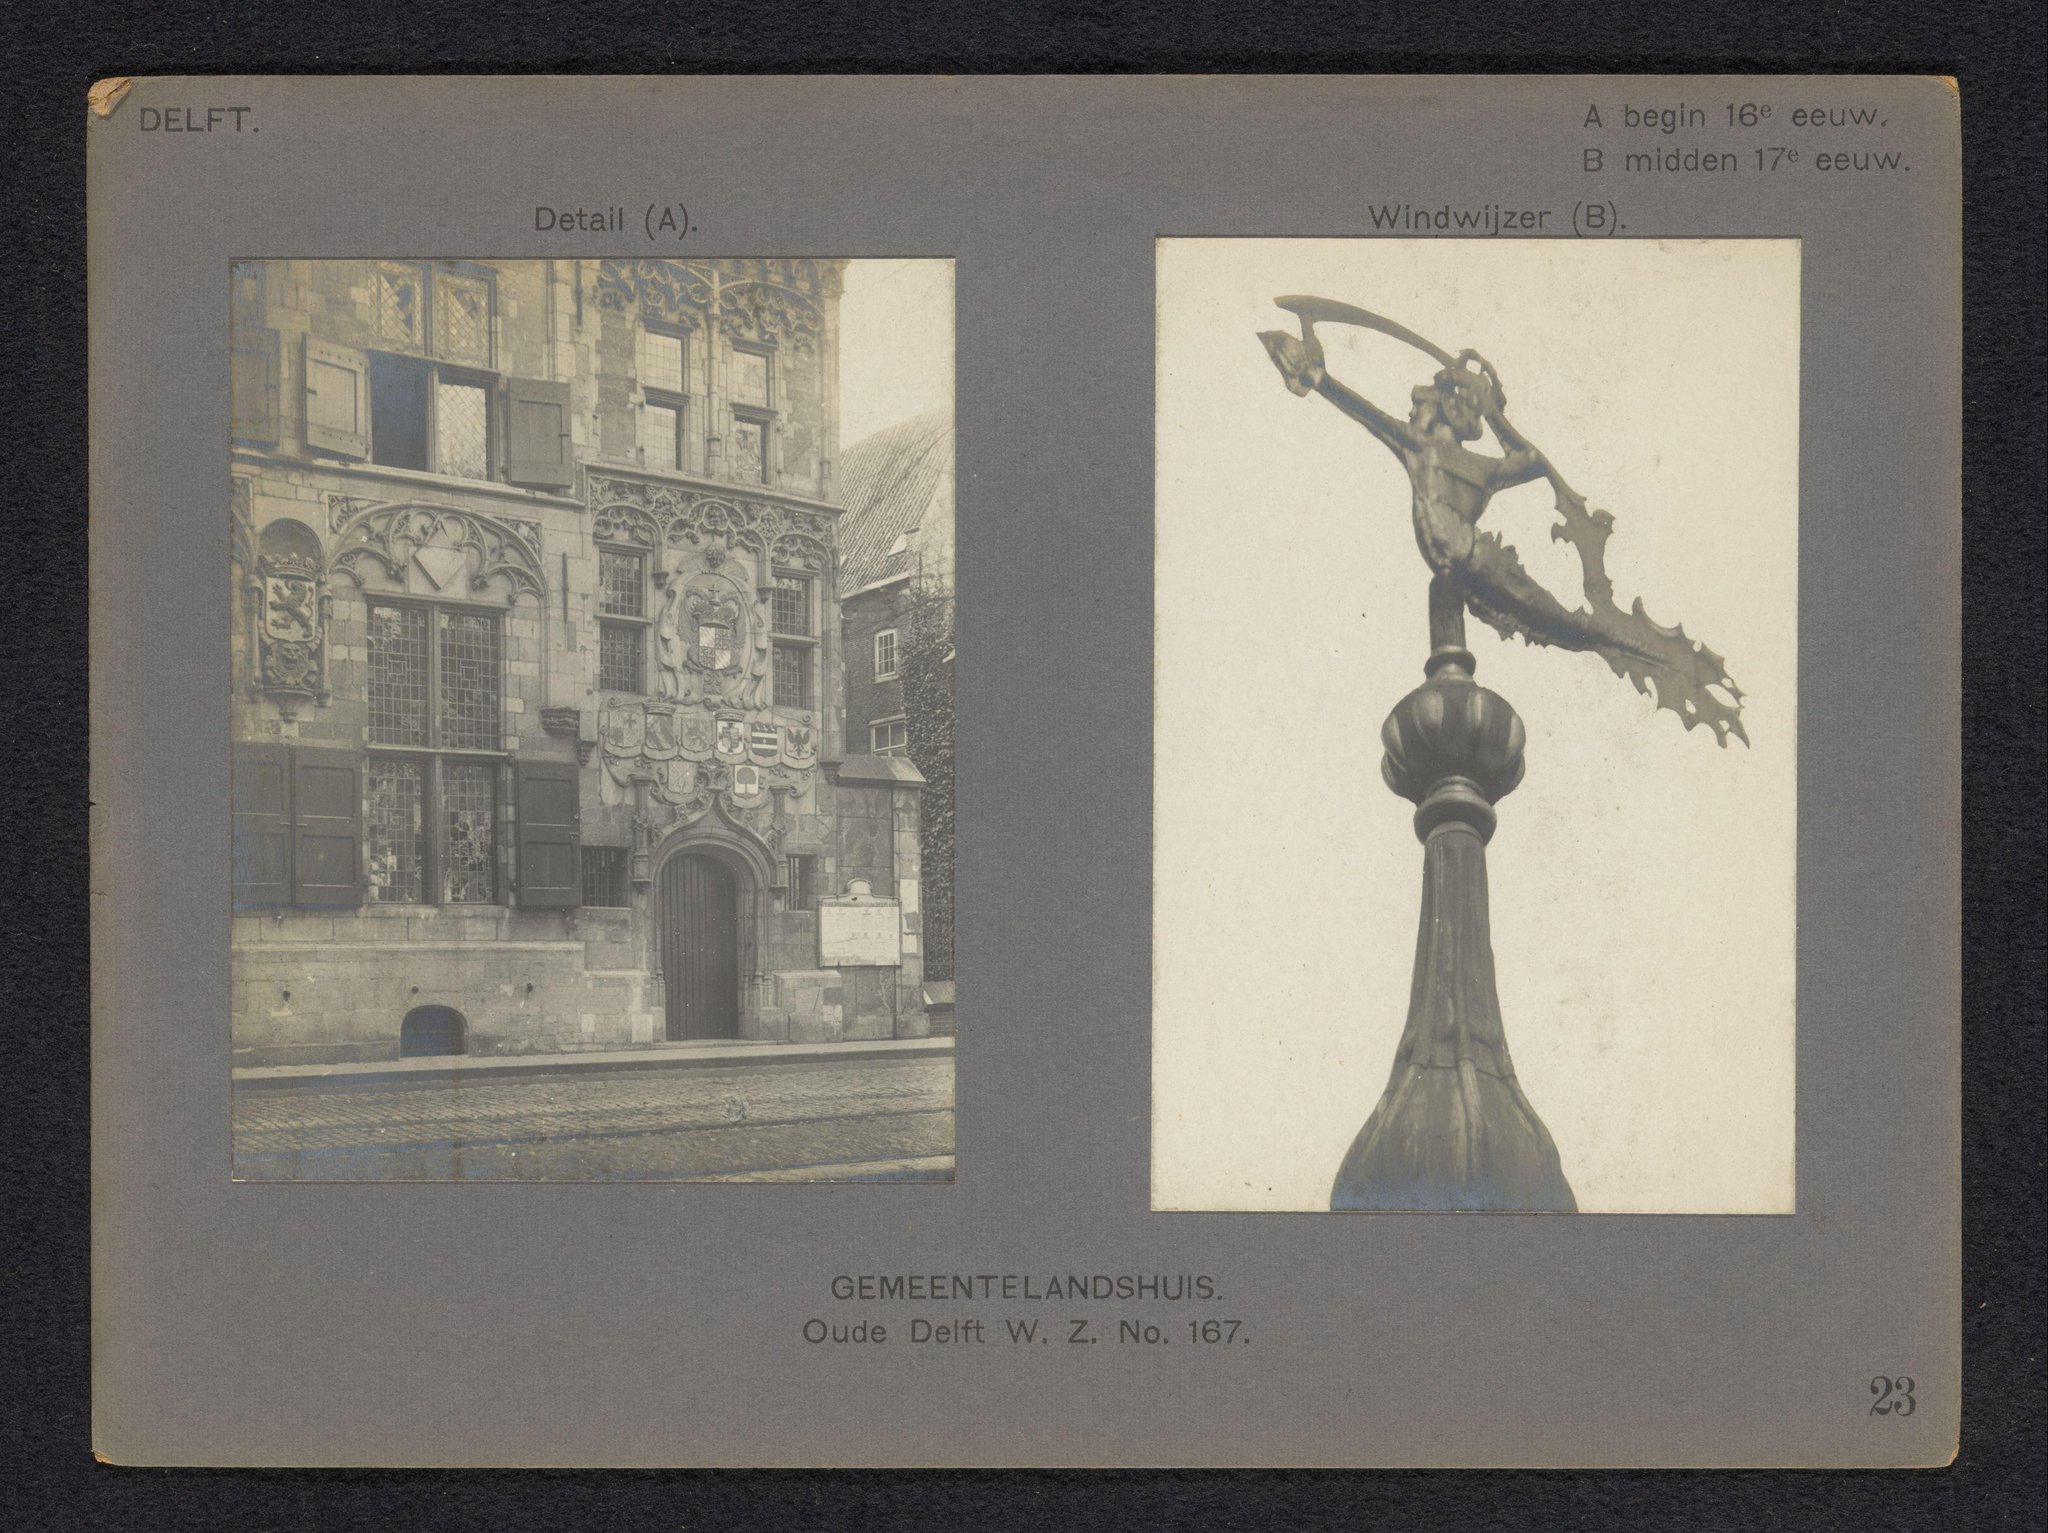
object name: photograph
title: Gemeentelandshuis. Oude Delft W.Z. No. 167. Detail (A). Windwijzer (B)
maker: Anonymous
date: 1900-1904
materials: cardboard, photographic support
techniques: gelatin silver print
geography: delft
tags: weather-vane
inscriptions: inscription: ‘Delft. A begin 16e eeuw. B midden 17e eeuw.’, inscription: ‘Het recht van reproductie dezer photo's wordt door den Uitgever voorbehouden.’, number: ‘23’